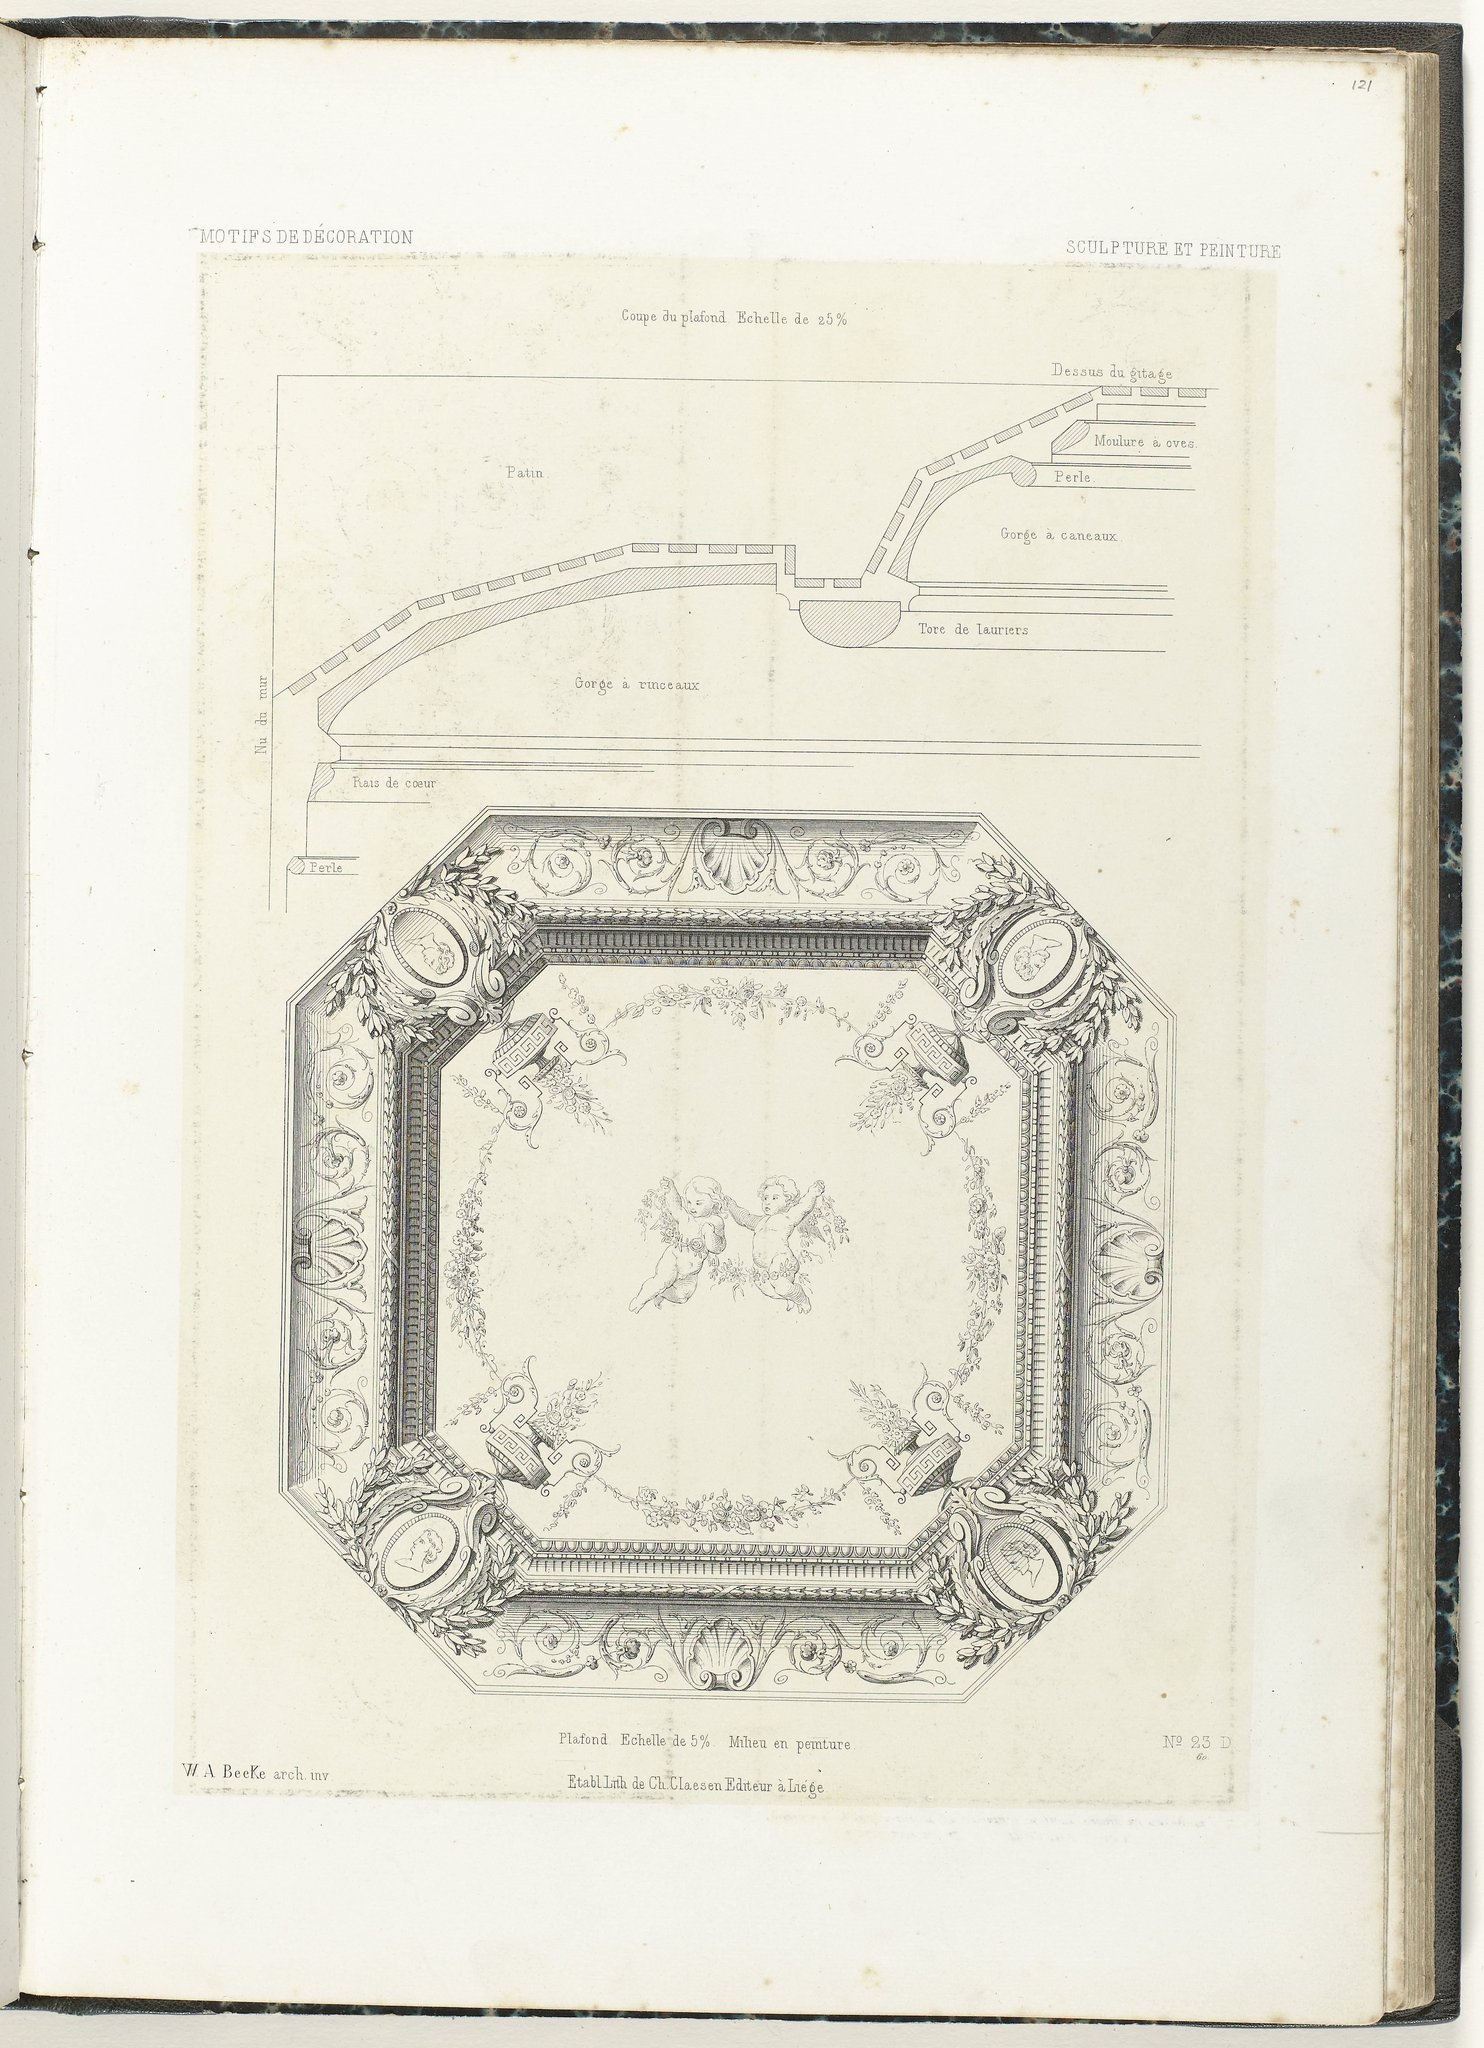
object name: print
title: Coupe du plafond / Plafond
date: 1866-1900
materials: paper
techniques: tone lithography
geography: liège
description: Achthoekig plafond met in de hoeken ovale portretmedaillons en in het midden twee putti die een guirlande vasthouden van bloemen en bladeren. Linksboven staat: Motifs de décoration, rechtsboven: Sculpture et peinture, rechtsonder: N° 23.D. 60.